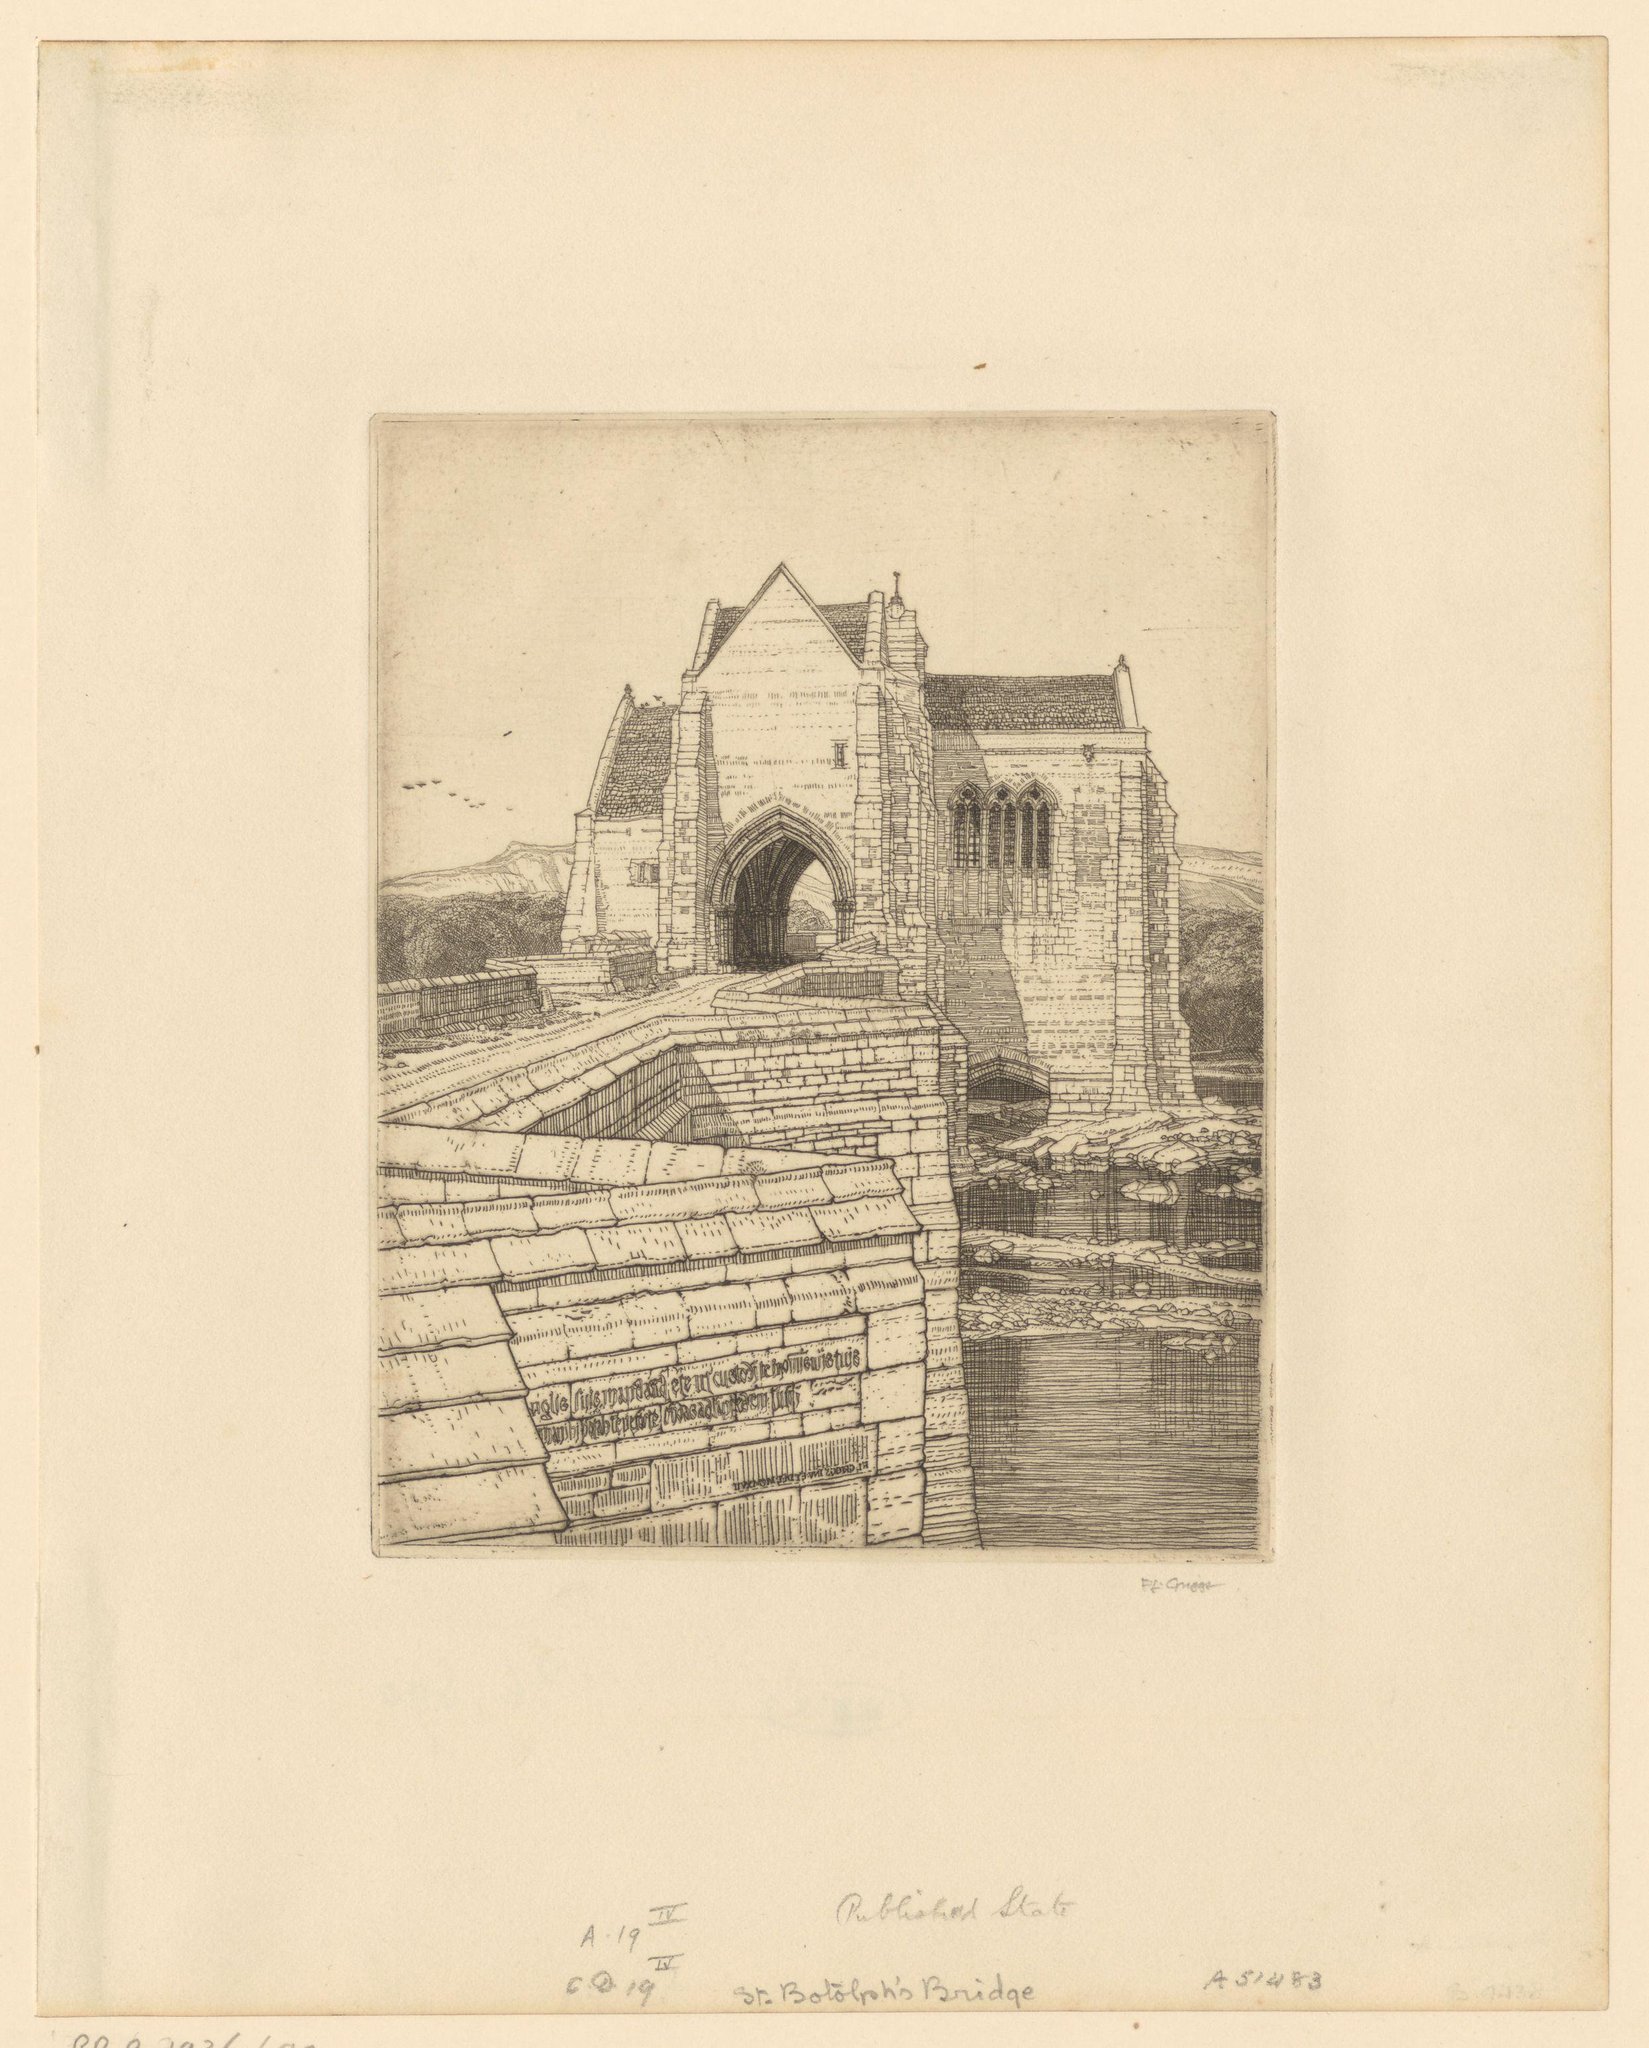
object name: print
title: St. Botolph's Bridge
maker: frederick landseer maur griggs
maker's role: print maker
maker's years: 1876-1938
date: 1917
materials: paper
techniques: etching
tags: landscape with bridge, viaduct or aqueduct, church (exterior) - qq - small church, chapel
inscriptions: signature: ‘F.L. Griggs’, collector's mark: Lugt 2228